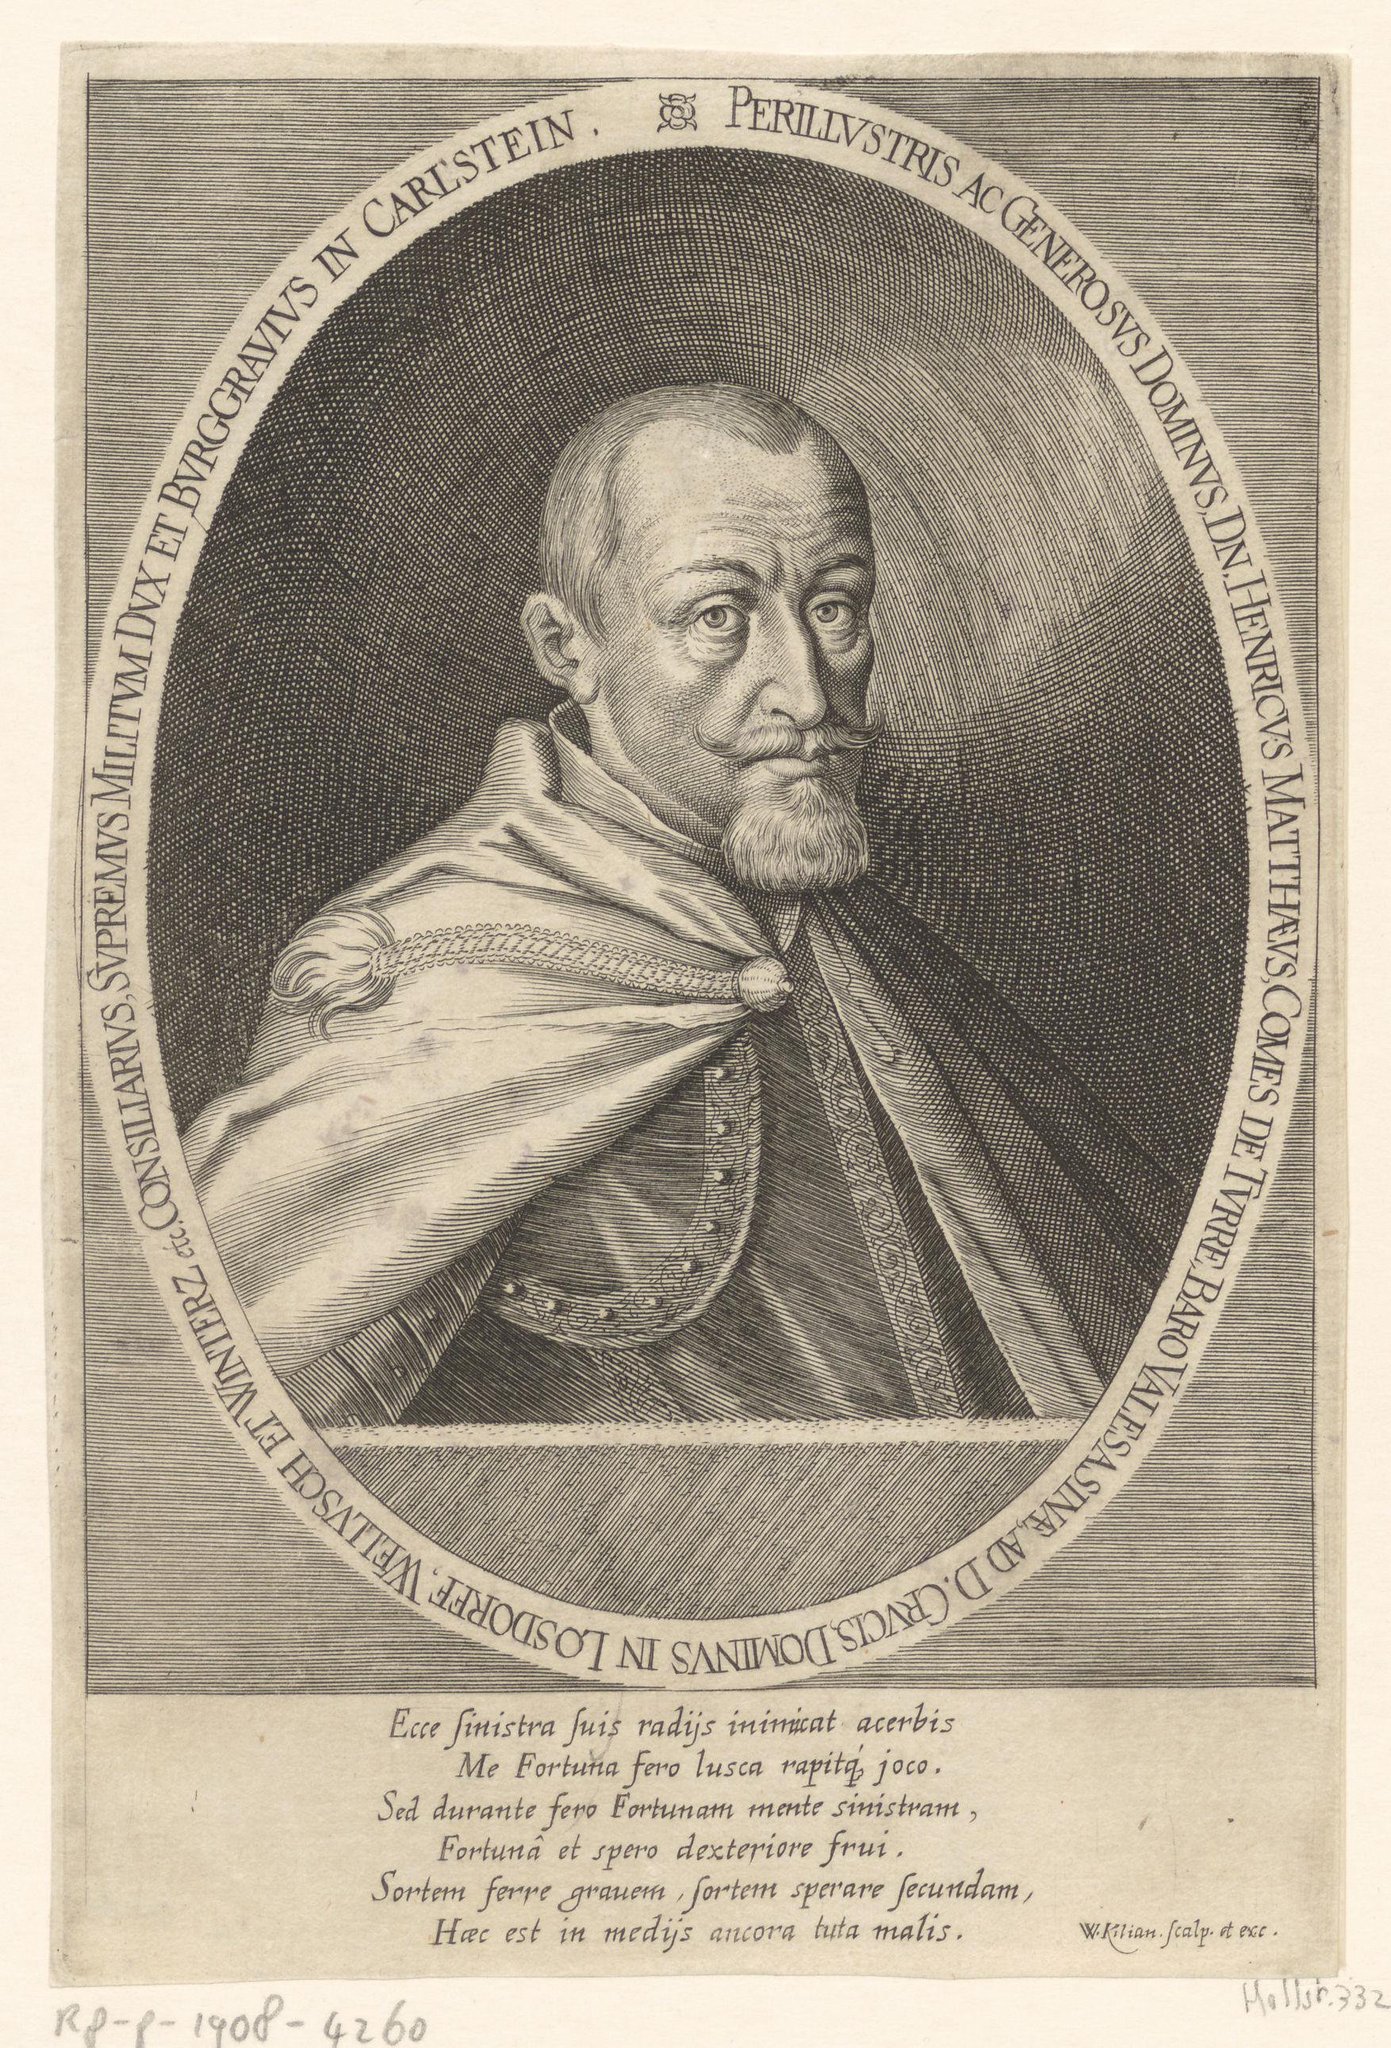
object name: print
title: Portret van Heinrich Matthias von Thurn-Valsassina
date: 1591-1641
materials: paper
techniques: engraving, etching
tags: politician, commander-in-chief, general, marshal, historical persons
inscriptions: collector's mark: Lugt 2228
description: Tekst in het Latijn in de omlijsting en in de ondermarge.